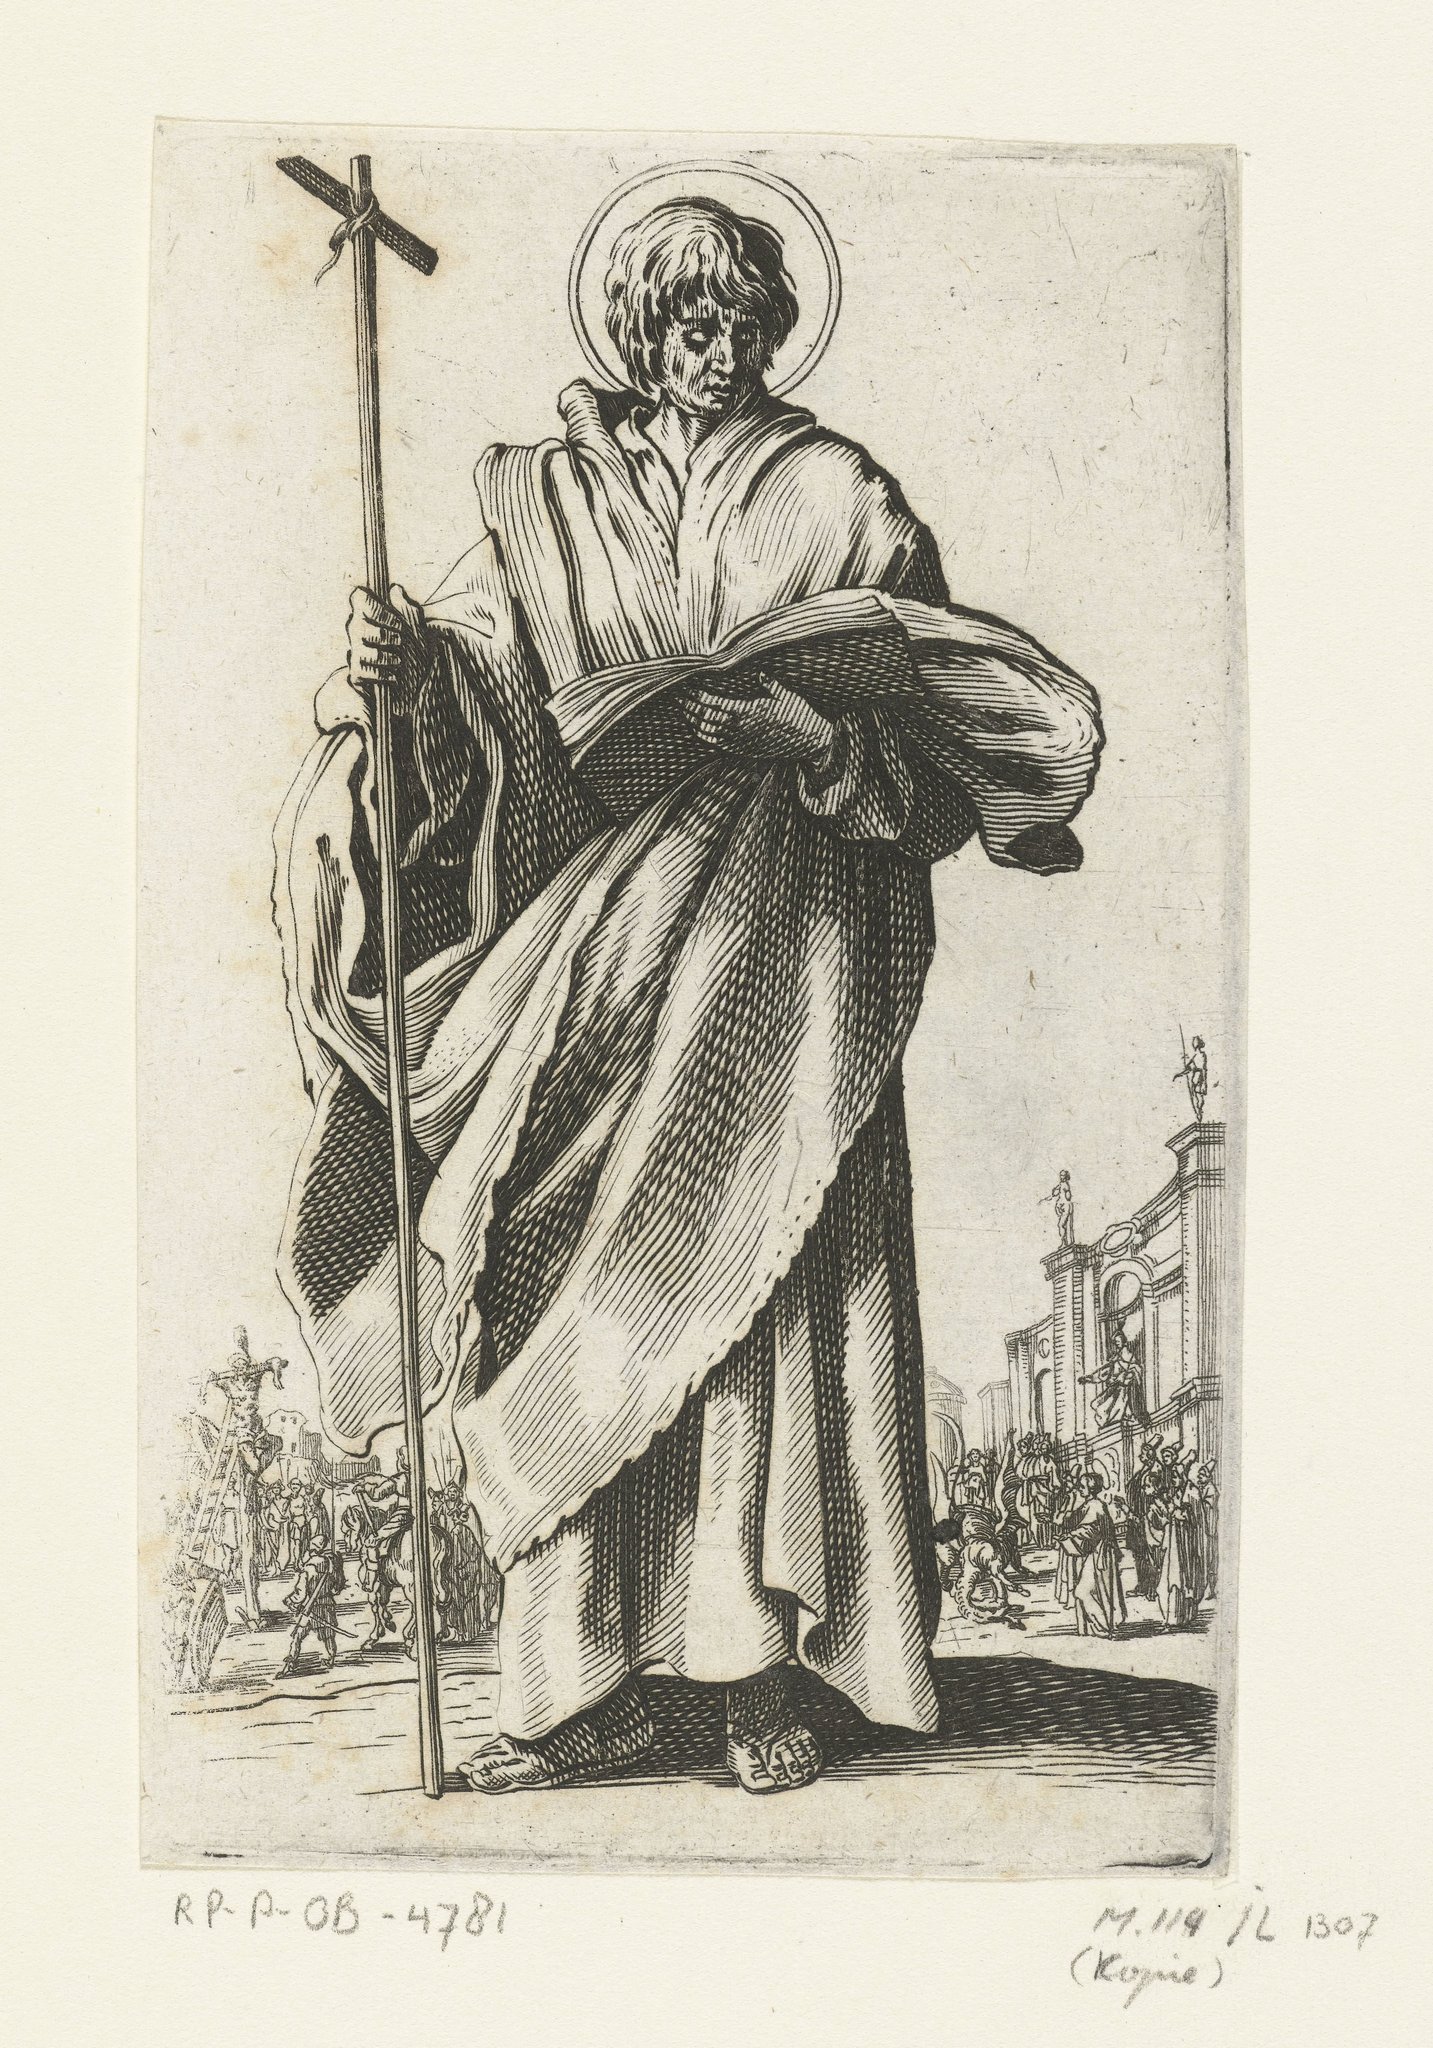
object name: print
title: Kopieën naar 'De grote apostelen'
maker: Anonymous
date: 1631-1699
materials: paper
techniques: engraving, etching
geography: france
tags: the apostle philip; possible attributes: book, cross, dish with snake, lance, scroll, stone, sword, philip is crucified (sometimes upside down), story of the banishment of a dragon out of the temple of mars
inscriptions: collector's mark: Lugt 240